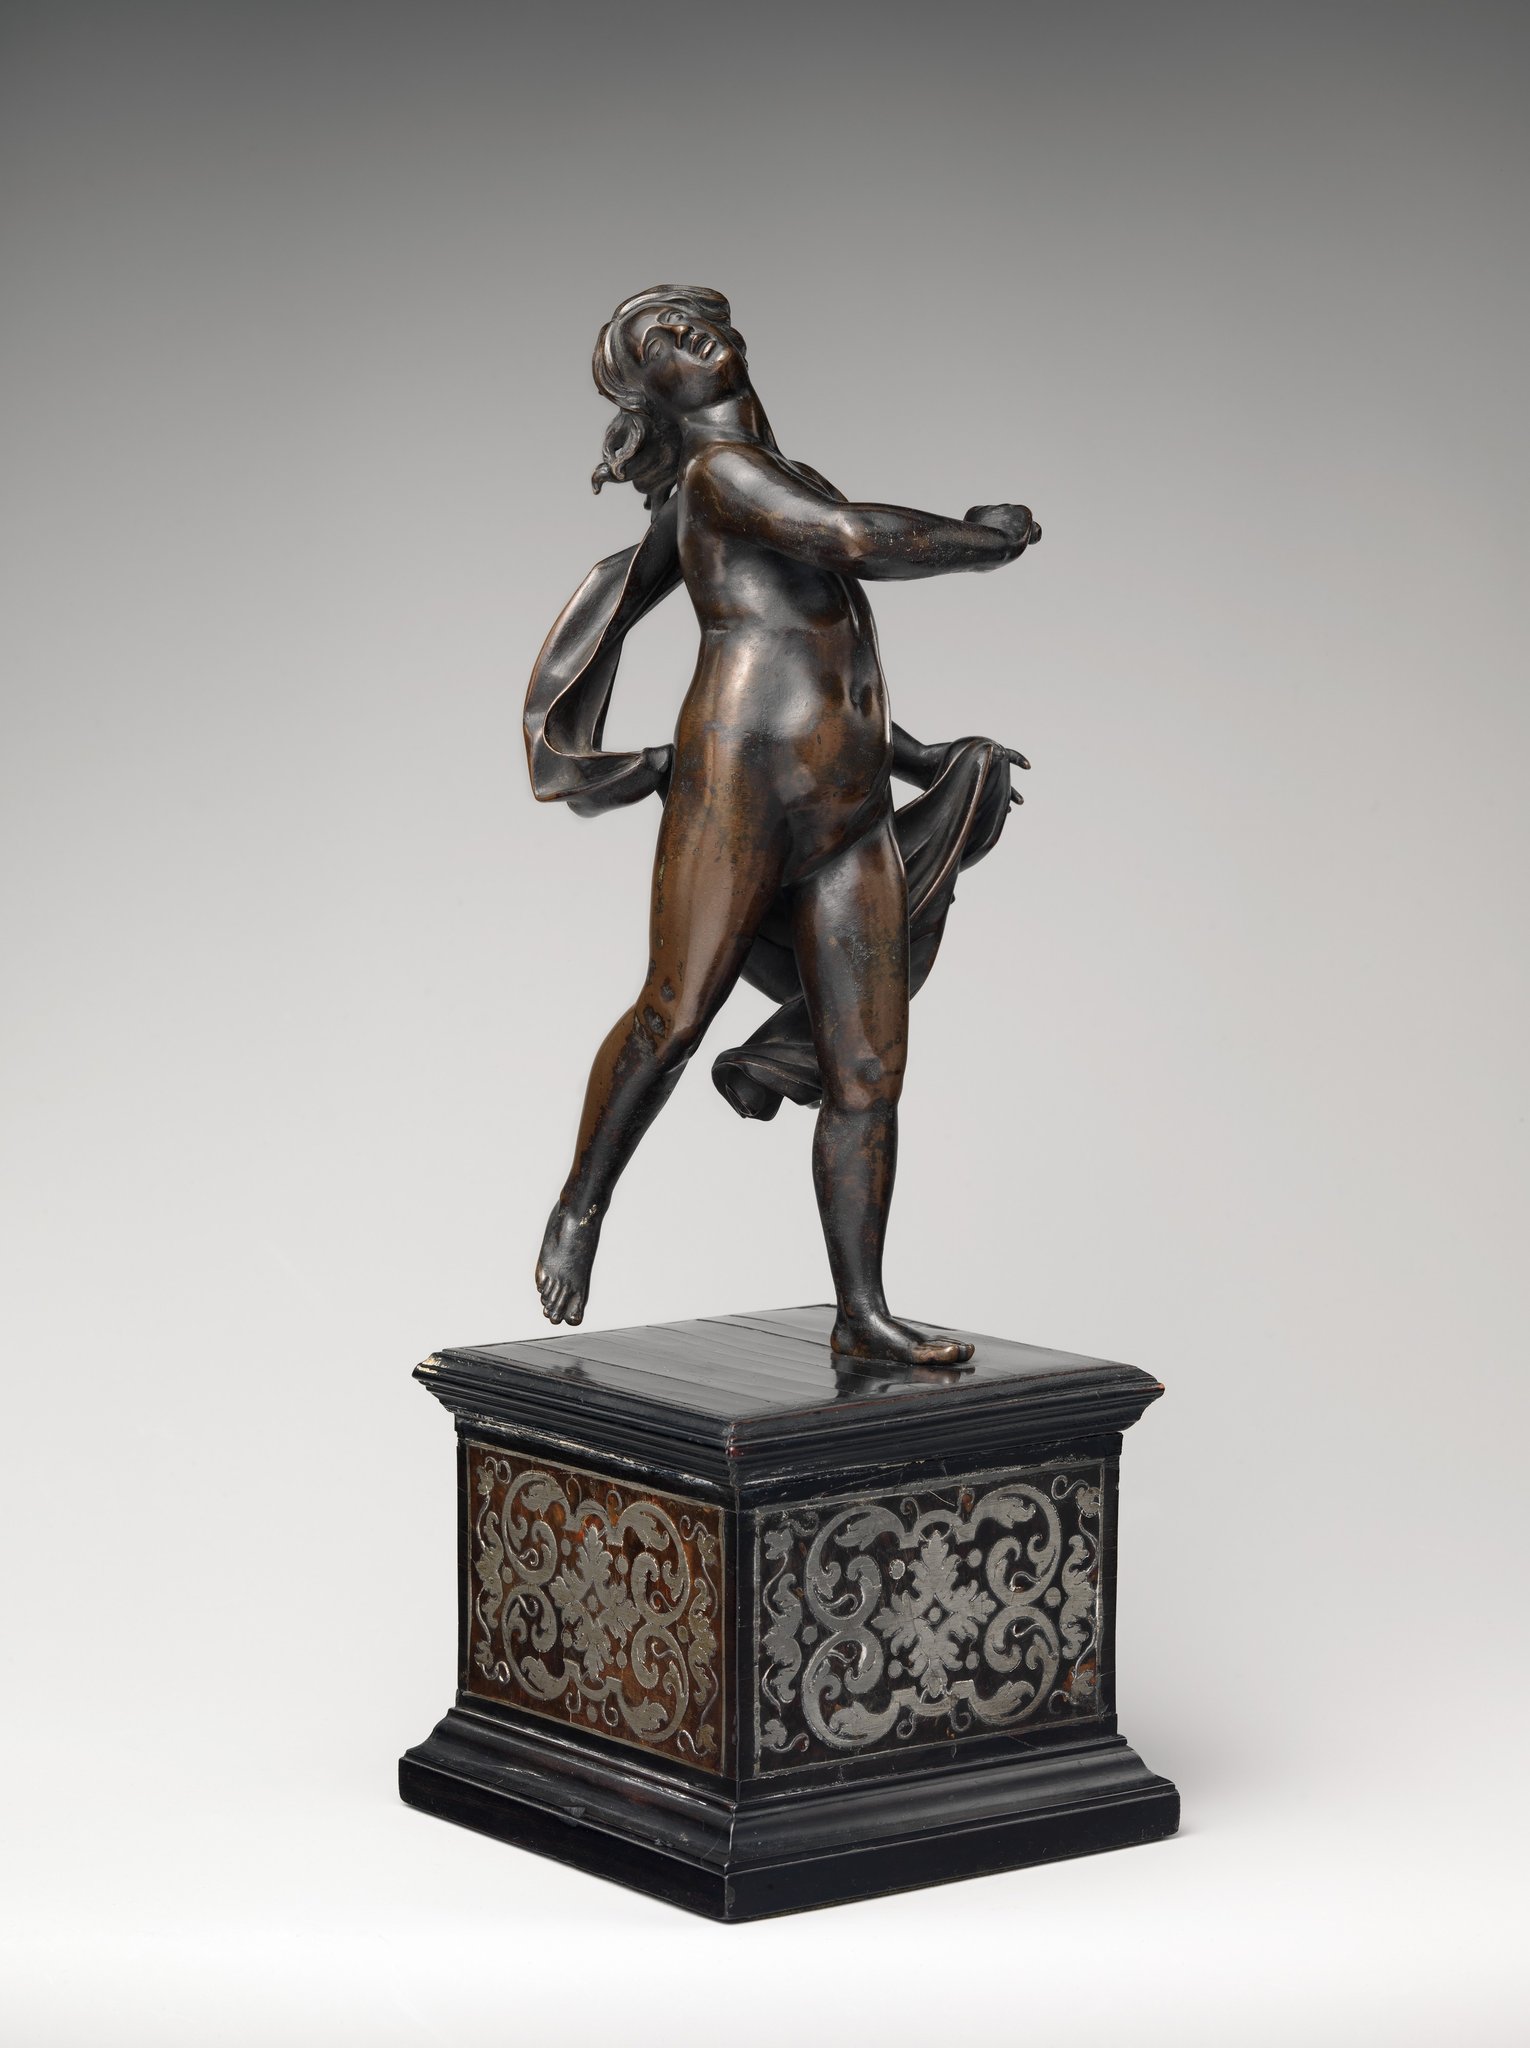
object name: statuette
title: The suicide of Dido, Queen of Carthage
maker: ferdinando tacca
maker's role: artist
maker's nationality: italian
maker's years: 1619-1686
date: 1667-1700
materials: bronze, wood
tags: queens,female nudes